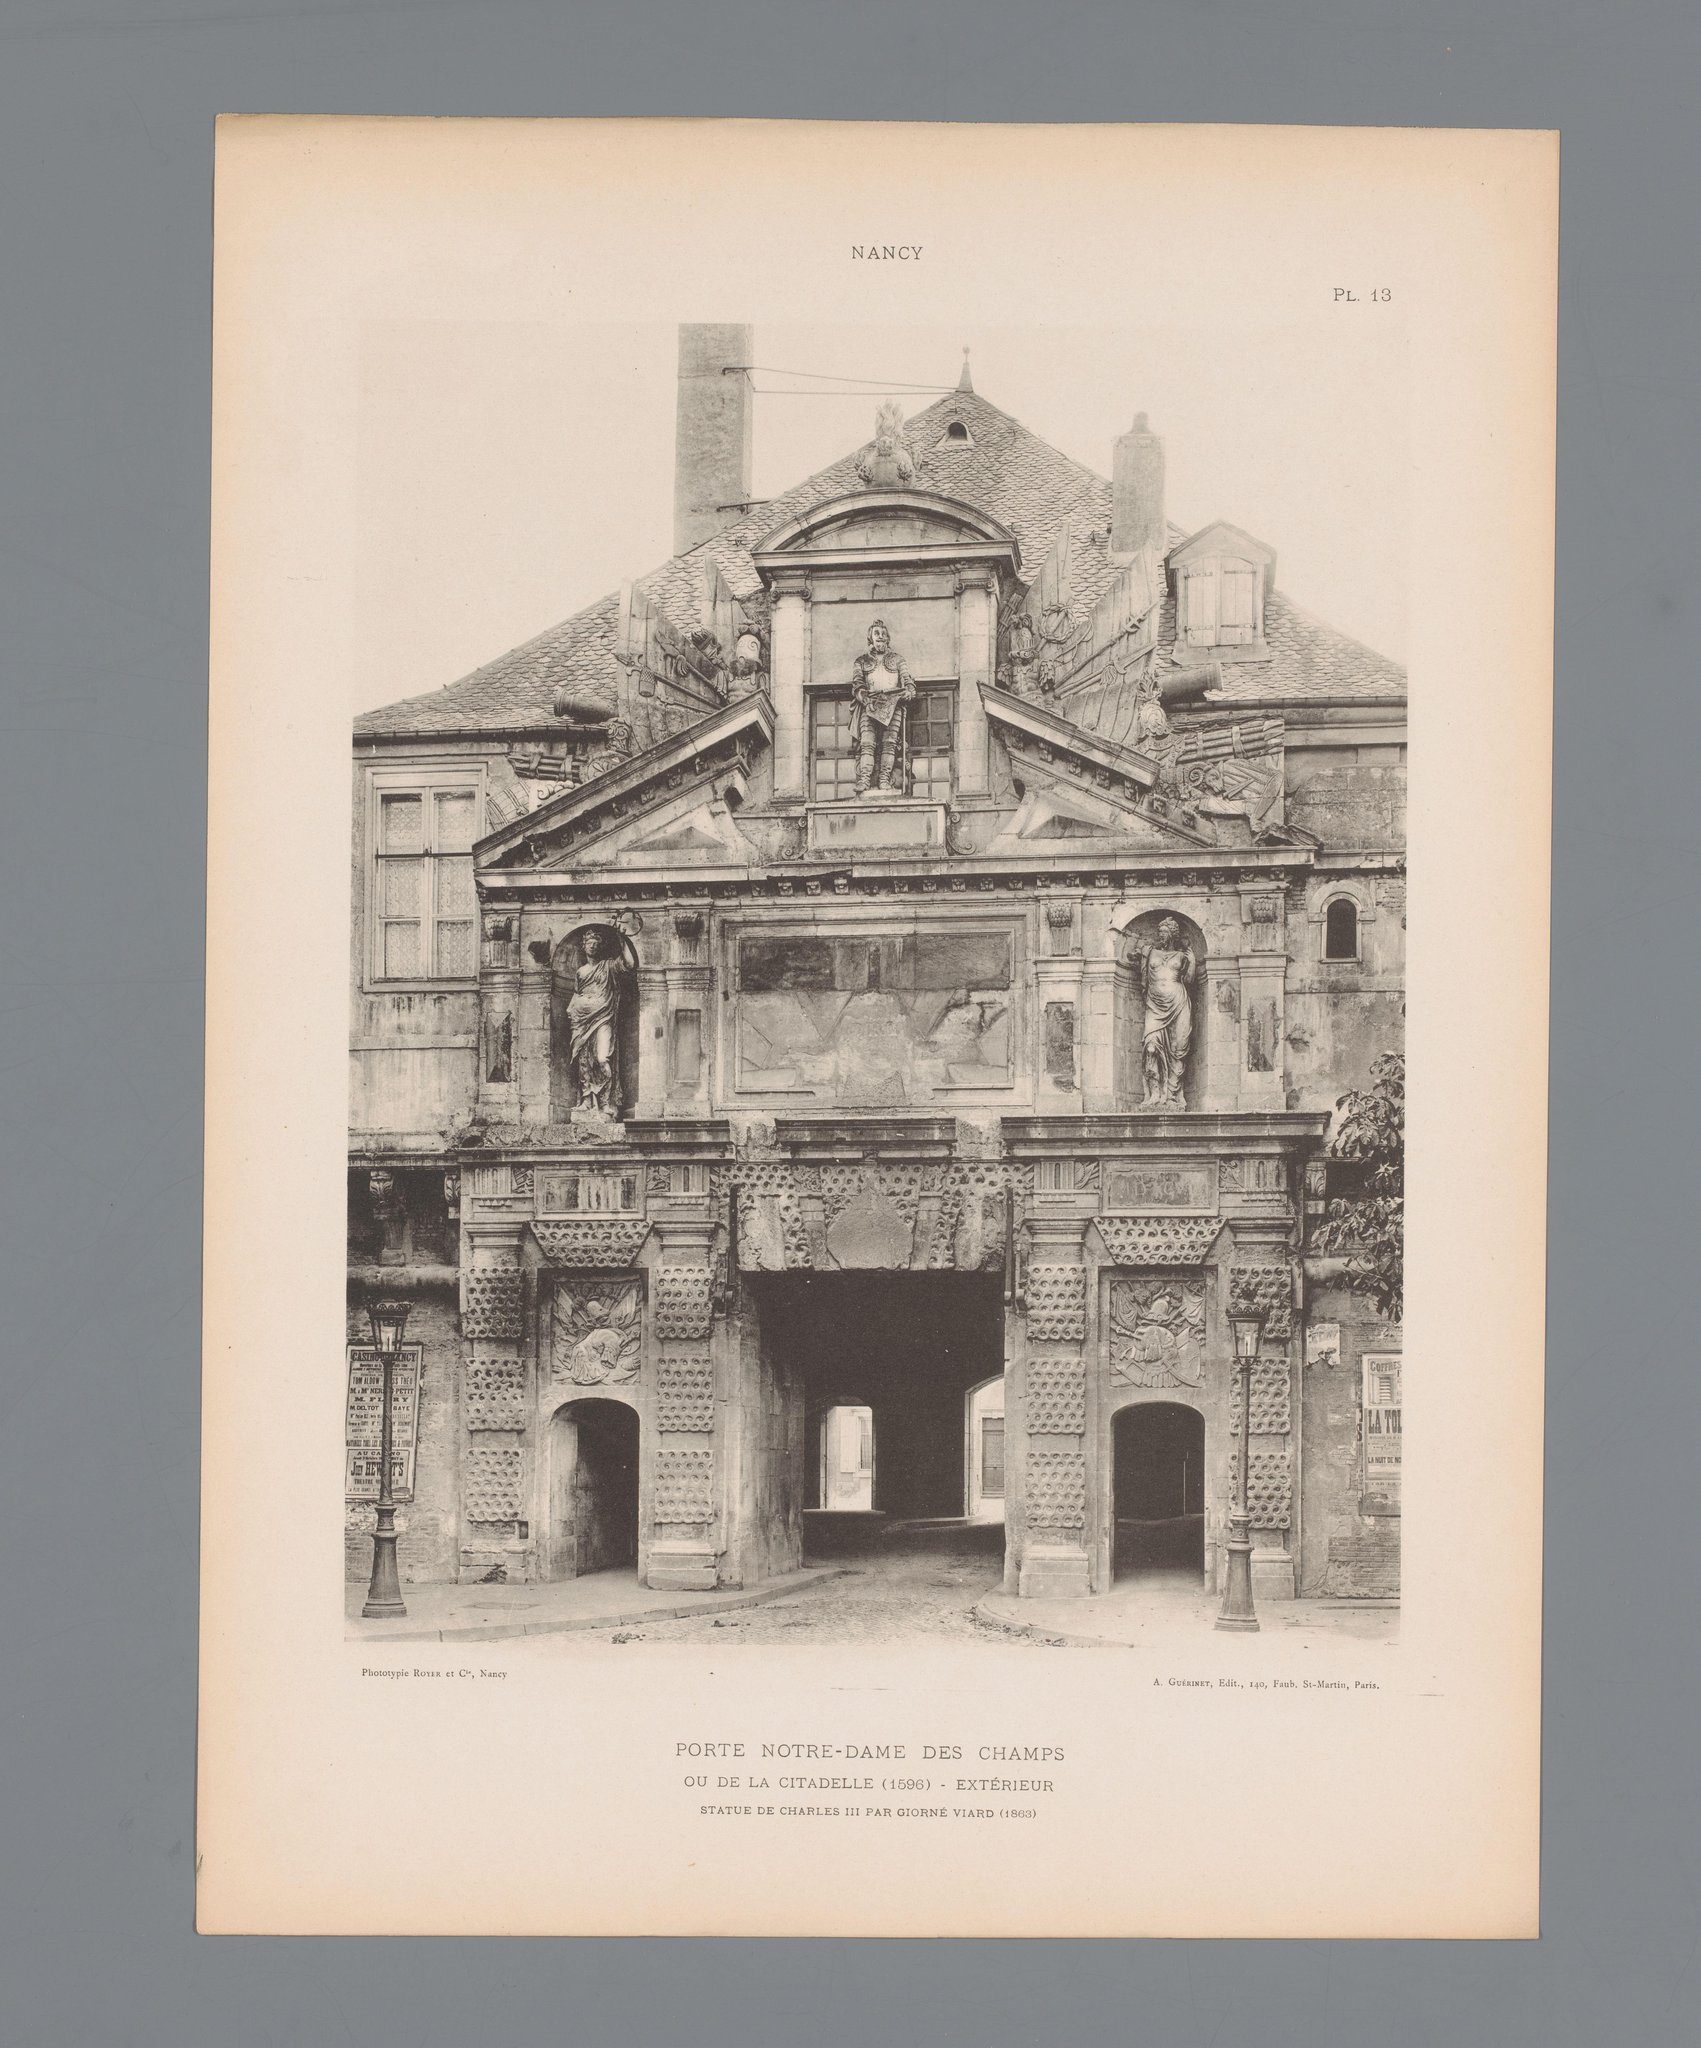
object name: photomechanical print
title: Gezicht op de Porte de la Citadelle te Nancy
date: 1891-1896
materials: paper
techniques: photograph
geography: paris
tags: city-gate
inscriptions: inscription: ‘Porte Notre-Dame des Champs ou de la Citadelle (...)’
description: Deze prent maakt deel uit van een omslag met 103 prenten op 101 bladen en een titelblad.